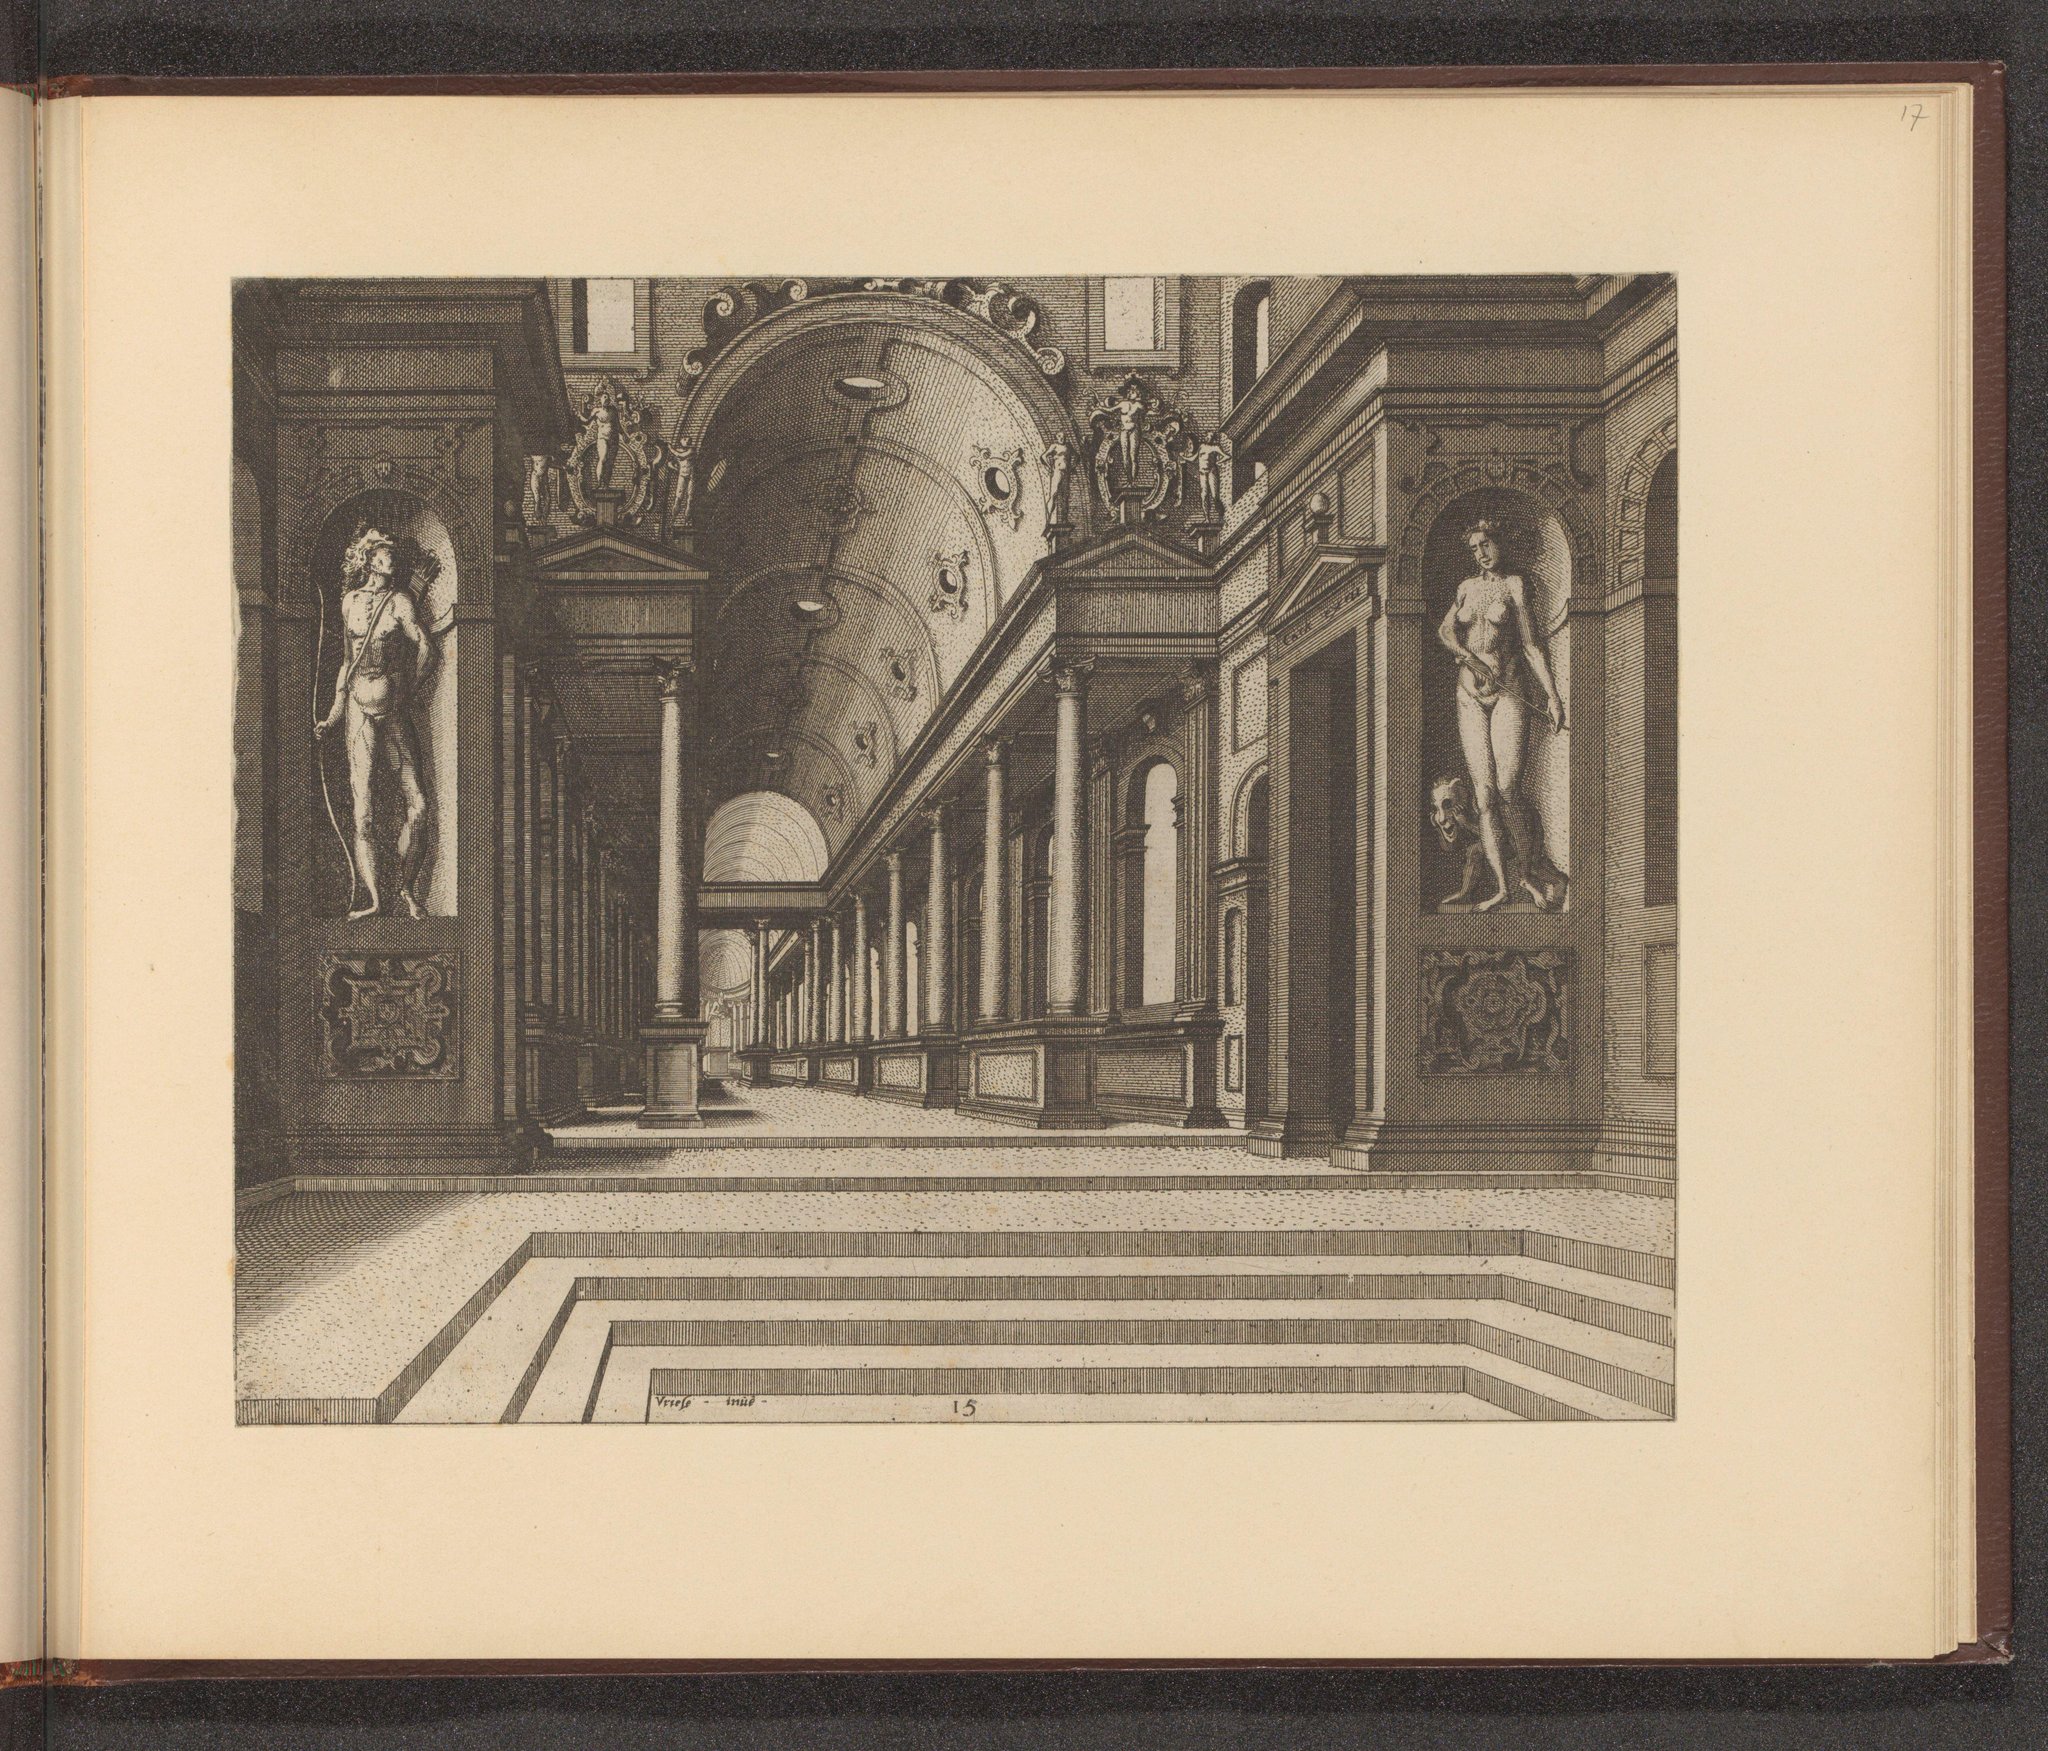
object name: print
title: Zicht in een kerk met standbeelden van Apollo en Melpomene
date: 1563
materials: paper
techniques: etching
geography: antwerp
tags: (story of) apollo (phoebus), interior of church, melpomene (one of the muses); 'melpomene' (ripa)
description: Zicht in een kerk met op de voorgrond links en rechts standbeelden van Apollo en Melpomene. In de apsis Mozes met de tafelen van de wet. Prent maakt deel uit van een album.